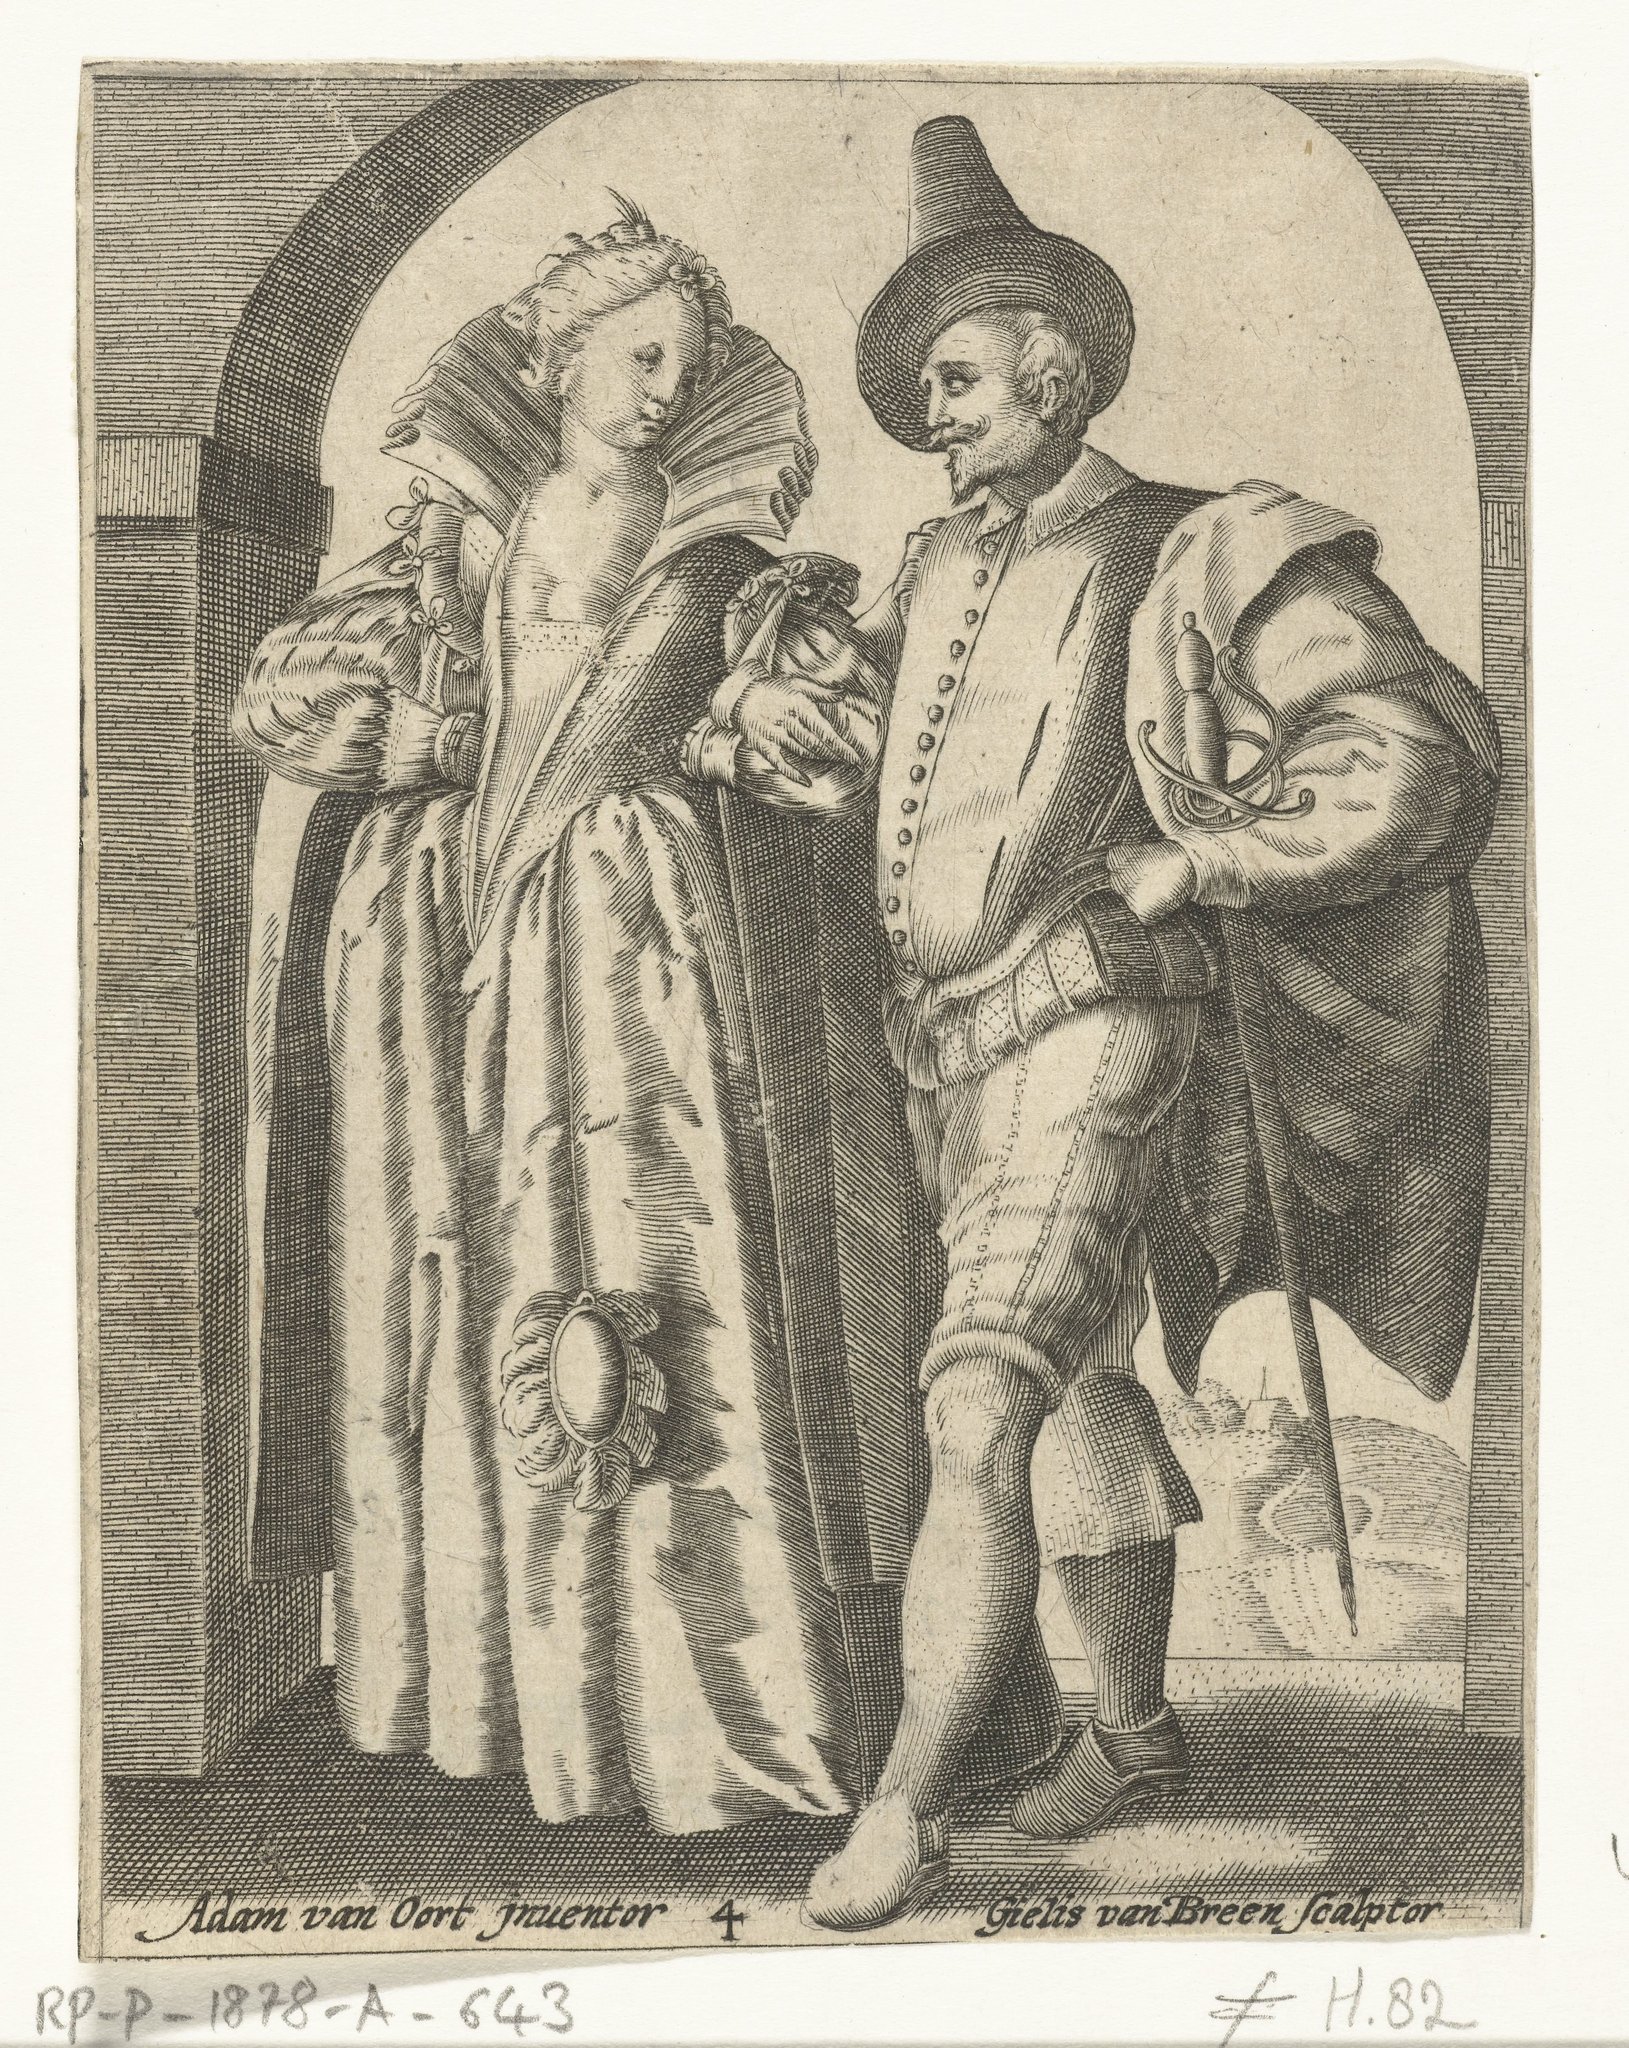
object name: costume print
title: Man en vrouw, gekleed volgens de mode van 1590-1600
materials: paper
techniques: engraving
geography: low countries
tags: cape (+ men's clothes), head-gear: hat (+ men's clothes), neck-gear: collar (+ women's clothes), clothes, costume (+ women's clothes), dress, gown (+ women's clothes), shoes, sandals (+ men's clothes), clothes, costume (+ men's clothes), trousers, breeches, etc. (breeches) (+ men's clothes), clothing for the upper part of the body (doublet) (+ men's clothes), sleeves (+ women's clothes), sleeves (+ men's clothes), netherlands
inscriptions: signature: ‘Adam van Oort inventor’, number: ‘4’, signature: ‘Gielis van Breen sculptor’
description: Een man met een puntige hoed op het hoofd loopt naar links met een dame die hem de linkerarm geeft. Zij draagt een waaier aan haar ceintuur. Het paar staat in een nis. Vierde prent uit een onbekende prentserie.